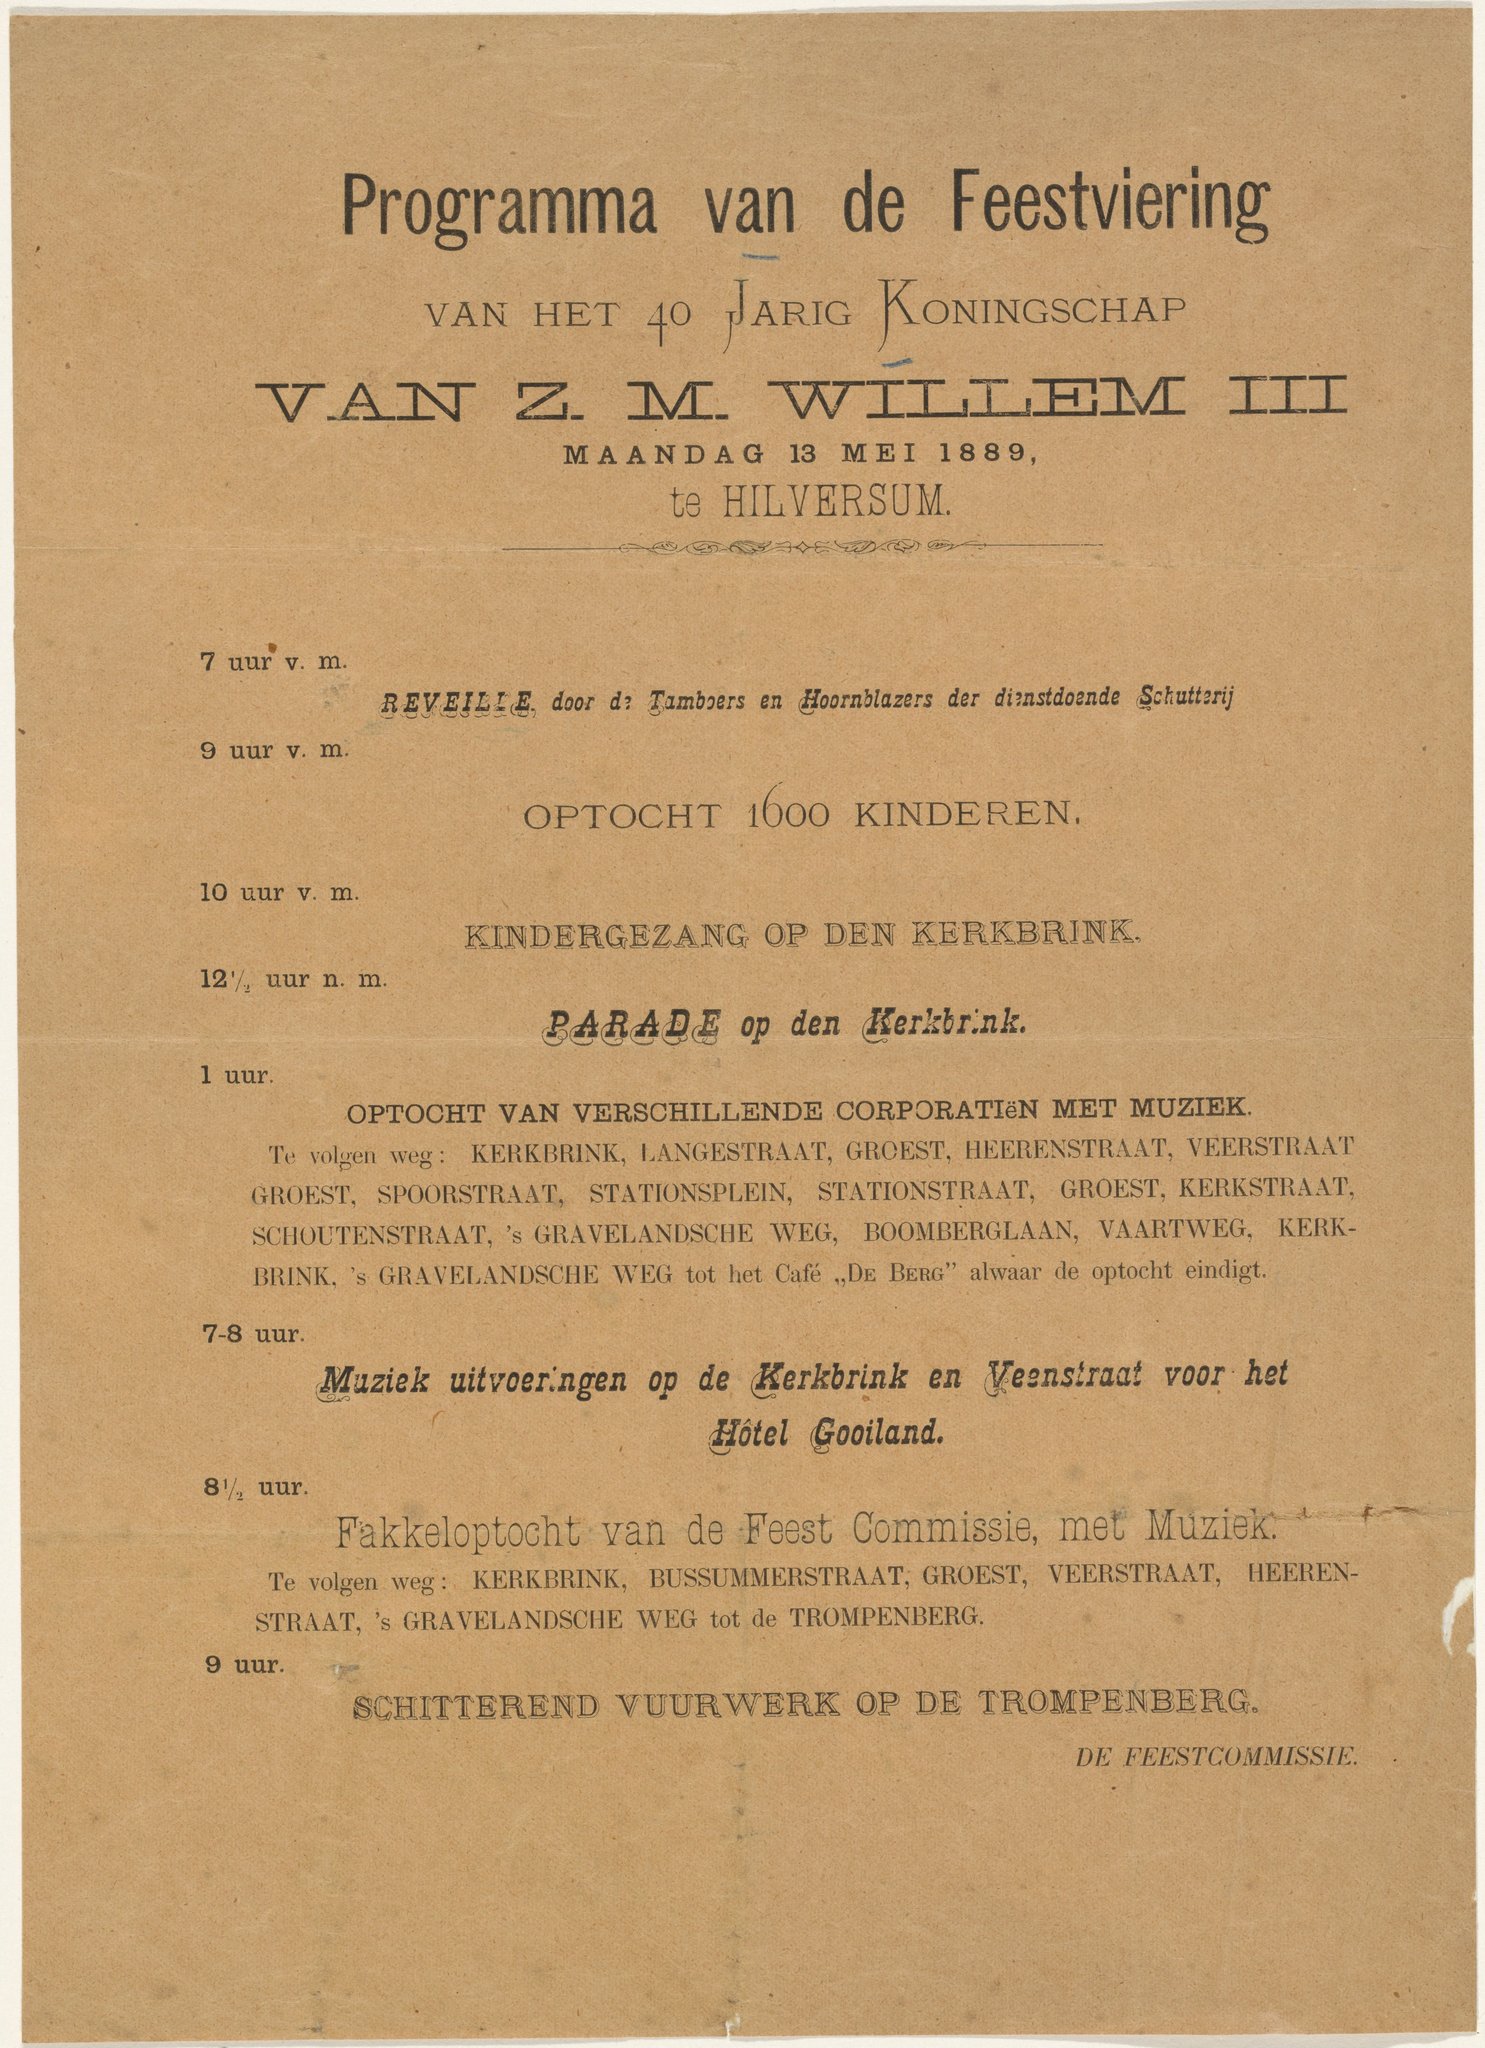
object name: text sheet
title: Programma van de viering van het 40-jarig regeringsjubileum van Willem III, koning der Nederlanden, te Hilversum op 13 mei 1889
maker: Anonymous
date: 1889-1891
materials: paper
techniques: letterpress printing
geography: netherlands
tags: brussels, willem iii (koning der nederlanden)